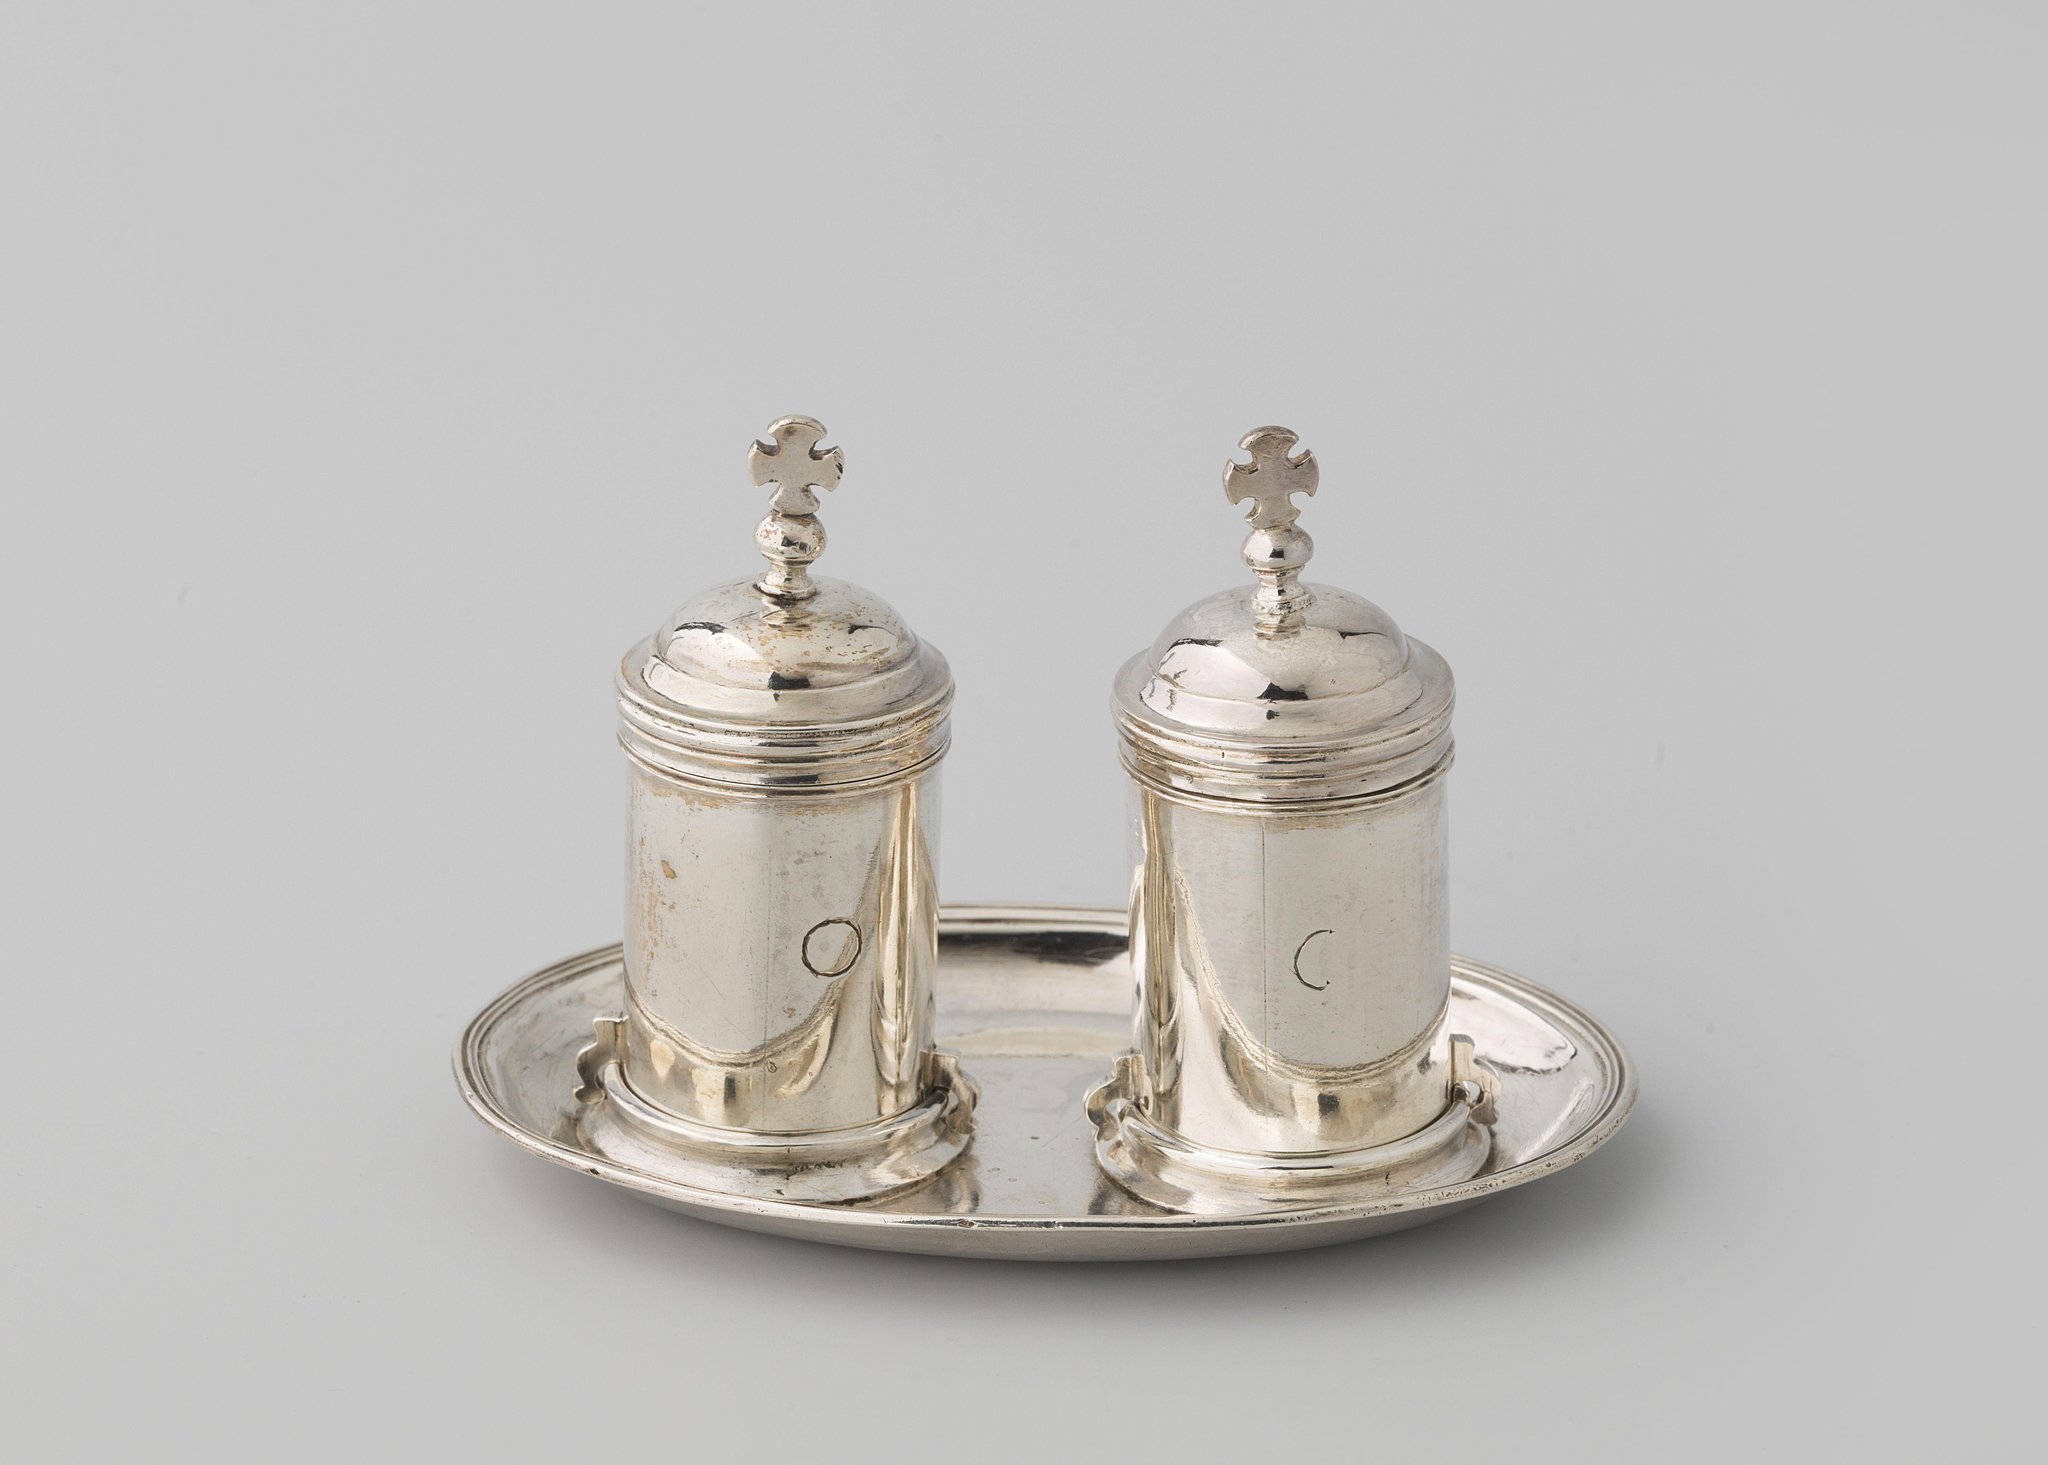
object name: blad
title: Blad, ovaal, behorend bij chrismatorium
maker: p.i. dupret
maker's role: silversmith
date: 1774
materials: silver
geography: ghent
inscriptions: mark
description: Chrismatory. Silver.Ghent, 1774, by P.I. Dupret.